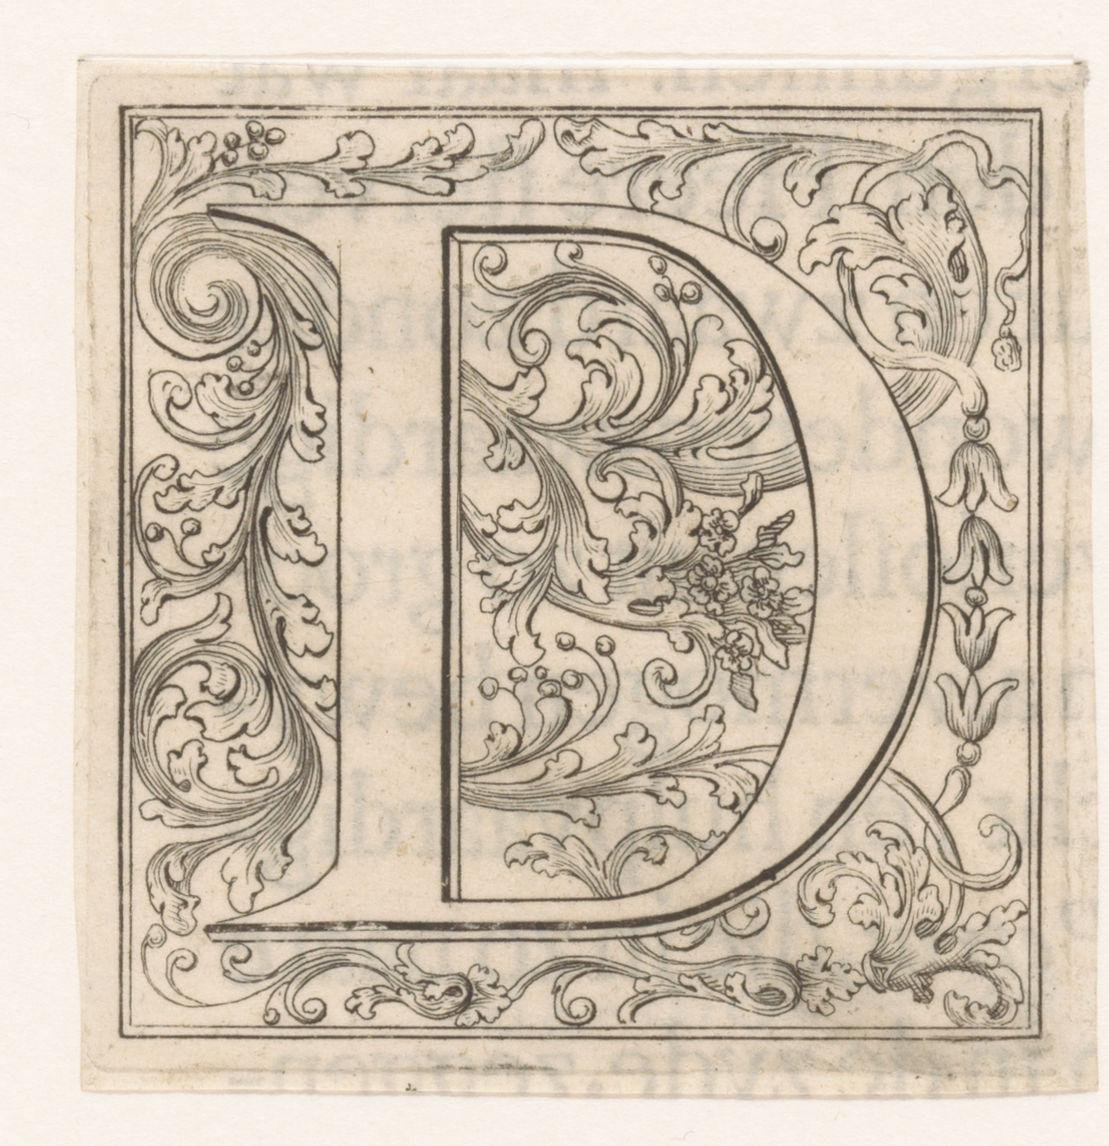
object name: ornament print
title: Letter D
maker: Anonymous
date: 1700-1799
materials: paper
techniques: etching, letterpress printing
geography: netherlands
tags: fancy letters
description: Letter D tegen een achtergrond met vlechtwerk.